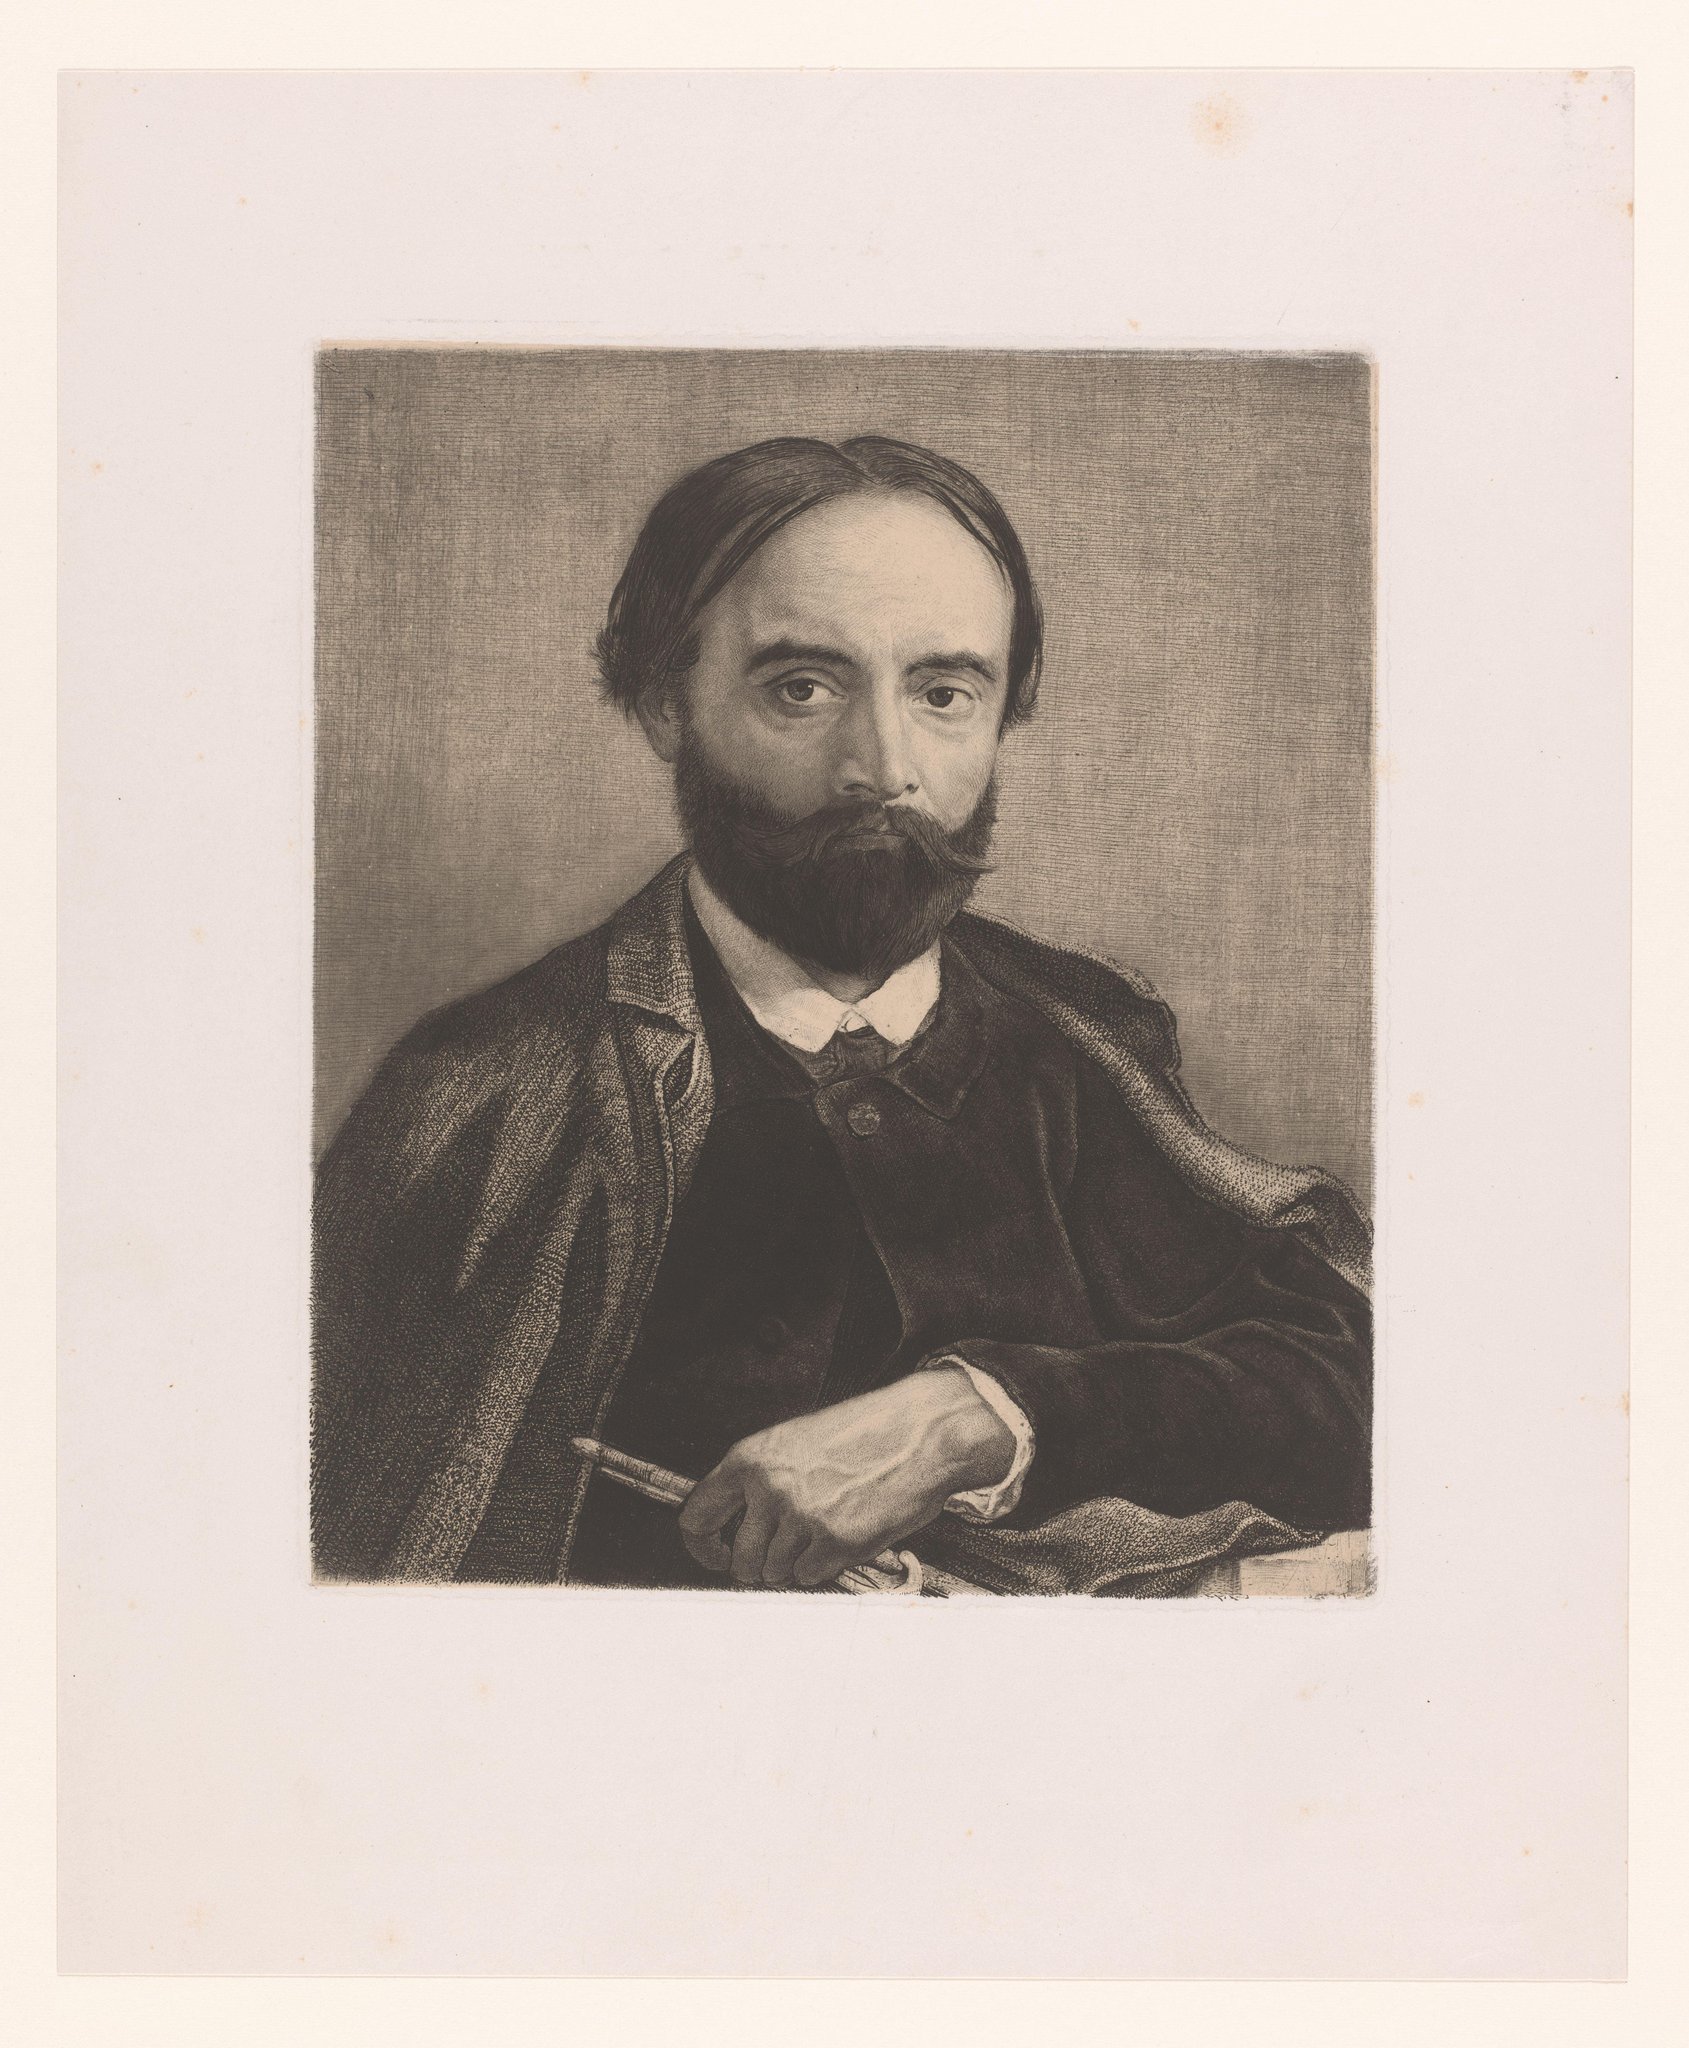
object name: print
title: Zelfportret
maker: charles verlat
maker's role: painter, print maker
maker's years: 1824-1890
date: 1868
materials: paper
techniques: drypoint, etching, intaglio, retroussage, roulette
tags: antwerp, painter, print maker, charles verlat, historical persons, portrait, self-portrait of artist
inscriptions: collector's mark: Lugt 2228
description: In 1868 maakte Verlat dit zelfportret. In 1882 bewerkte hij de plaat en gaf het gezicht oudere trekken. Dit deed hij in verschillende stappen waarvan de diverse staten ook in de coll. Rijksmuseum Amsterdam zijn. Het resultaat was een zelfportret dat meer paste bij hoe hij er op dat latere moment in zijn leven uitzag.